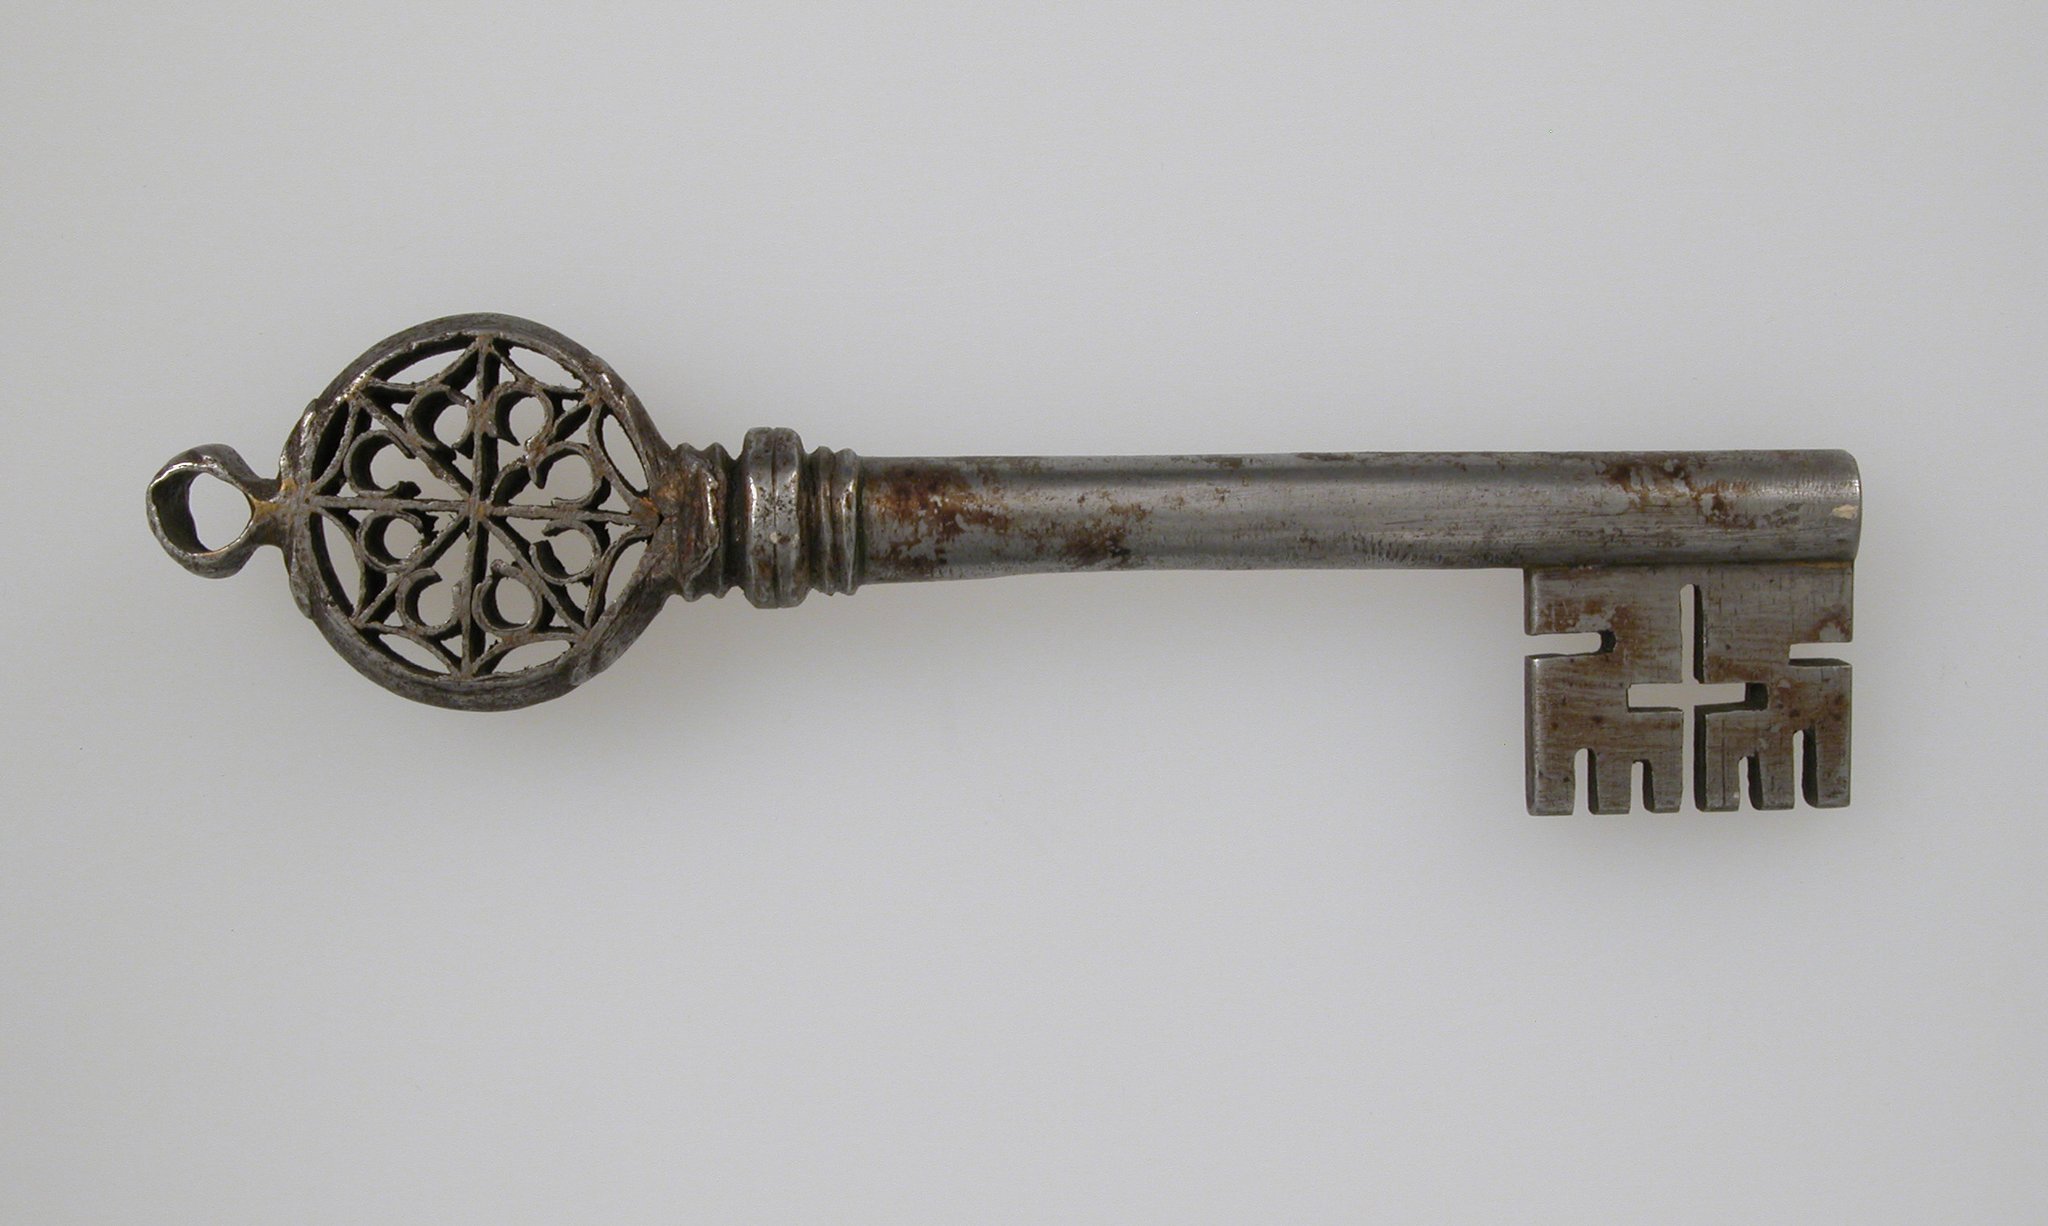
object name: key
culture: spanish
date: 1401-1600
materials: iron